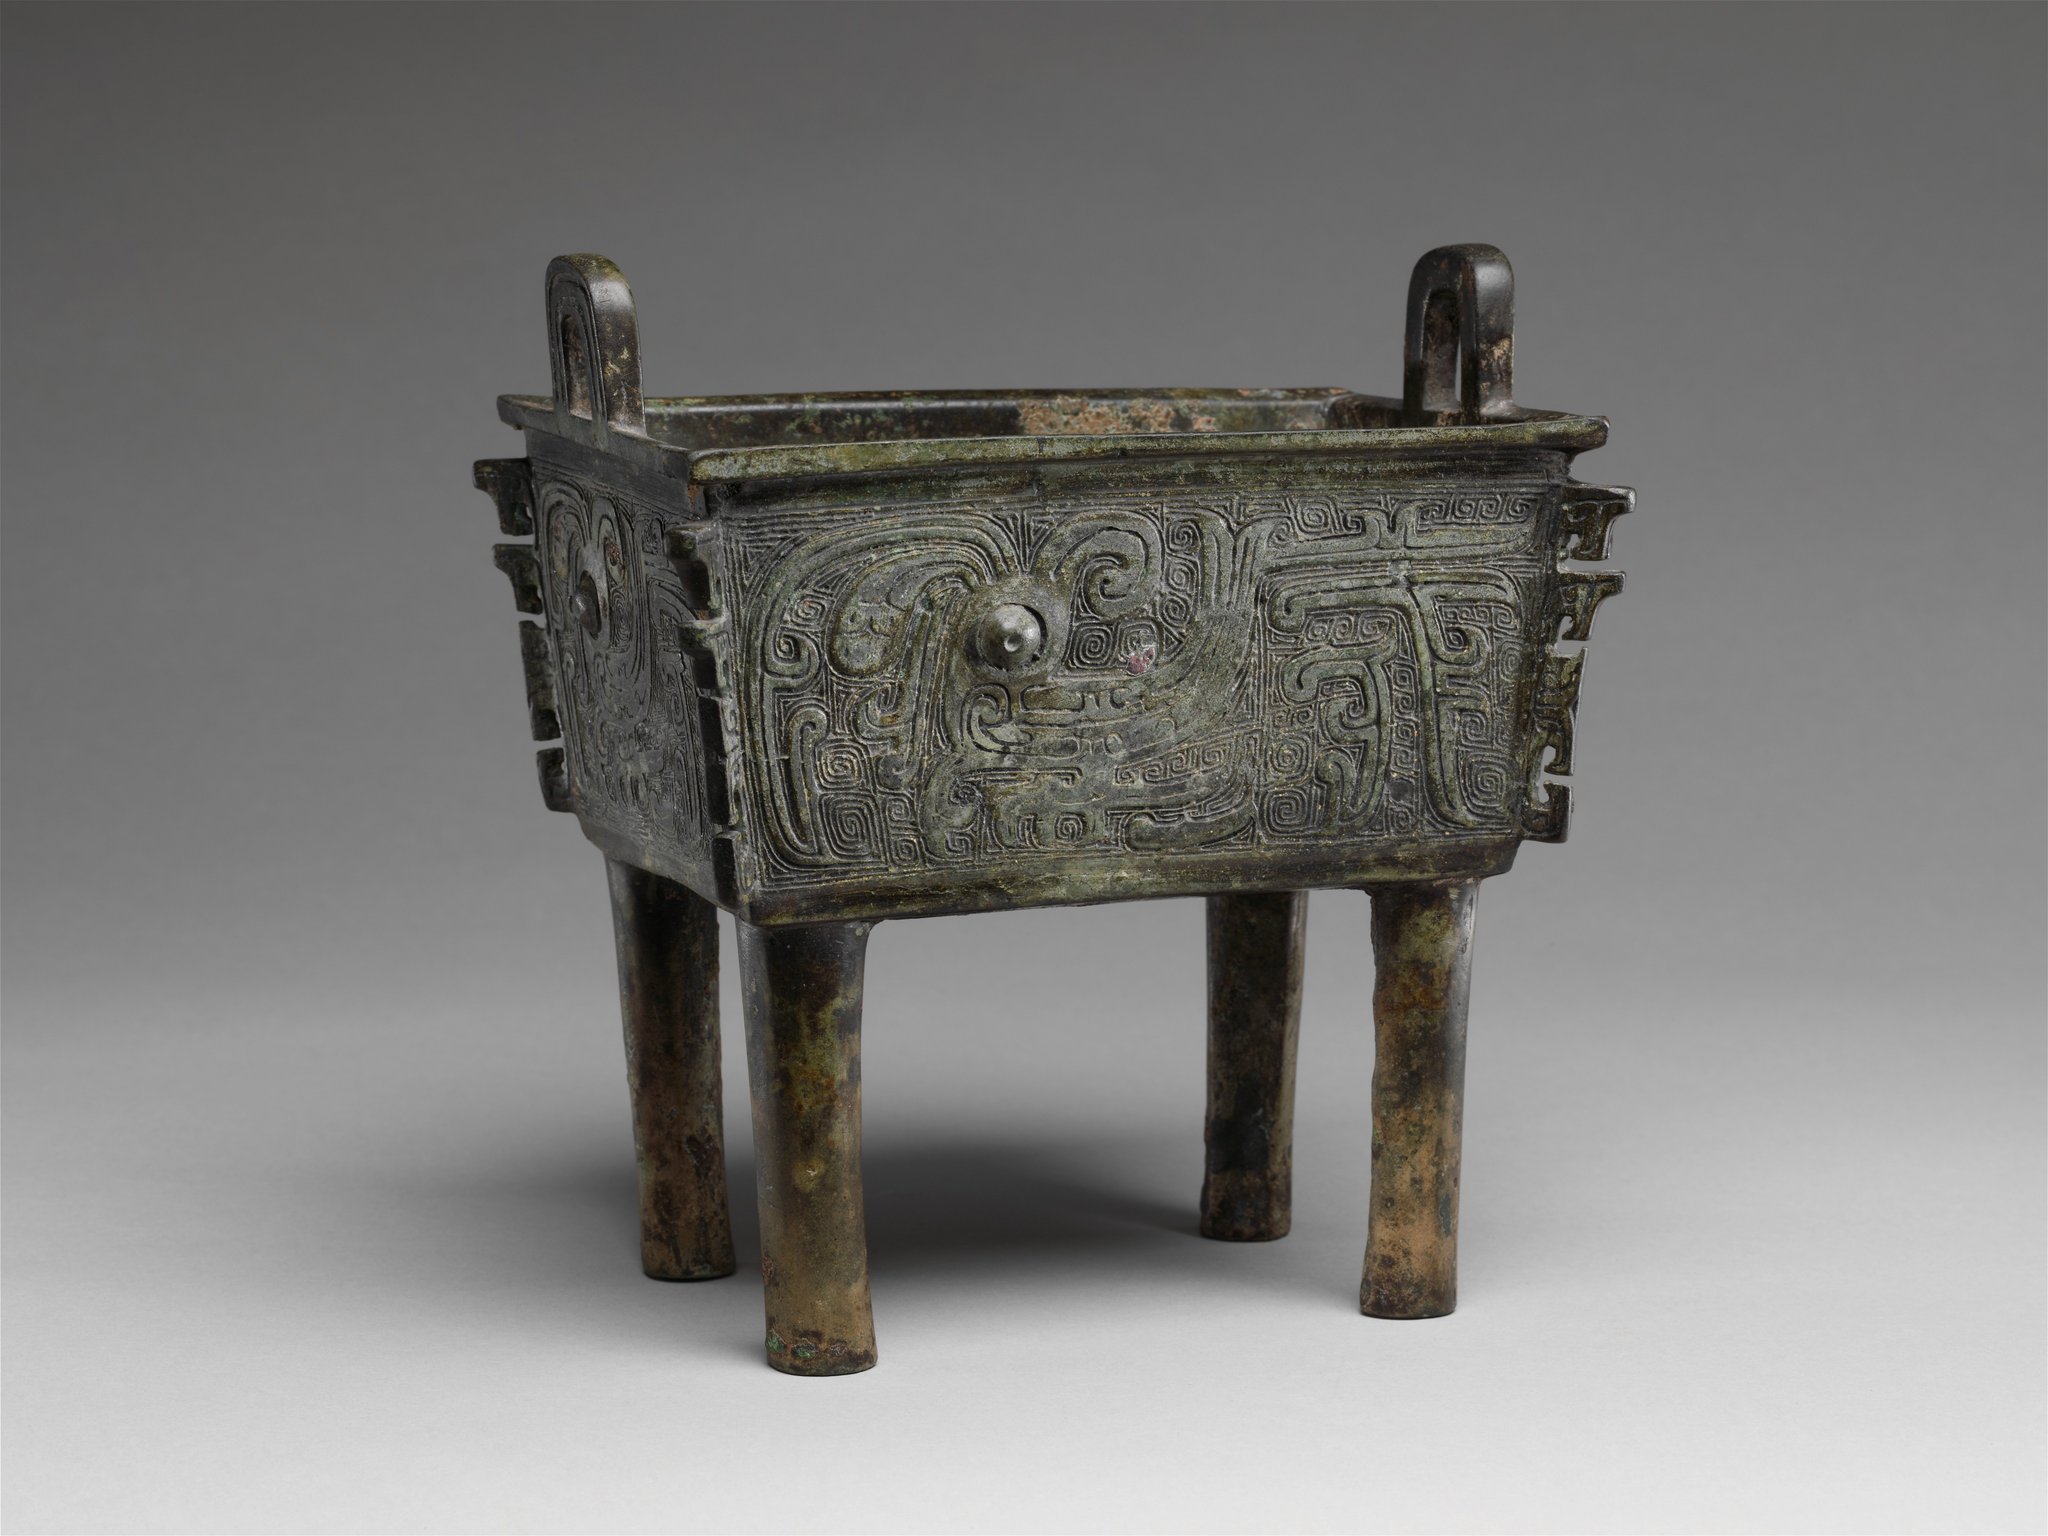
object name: cauldron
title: Rectangular cauldron (fangding)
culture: chinese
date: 1000-968 BCE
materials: bronze